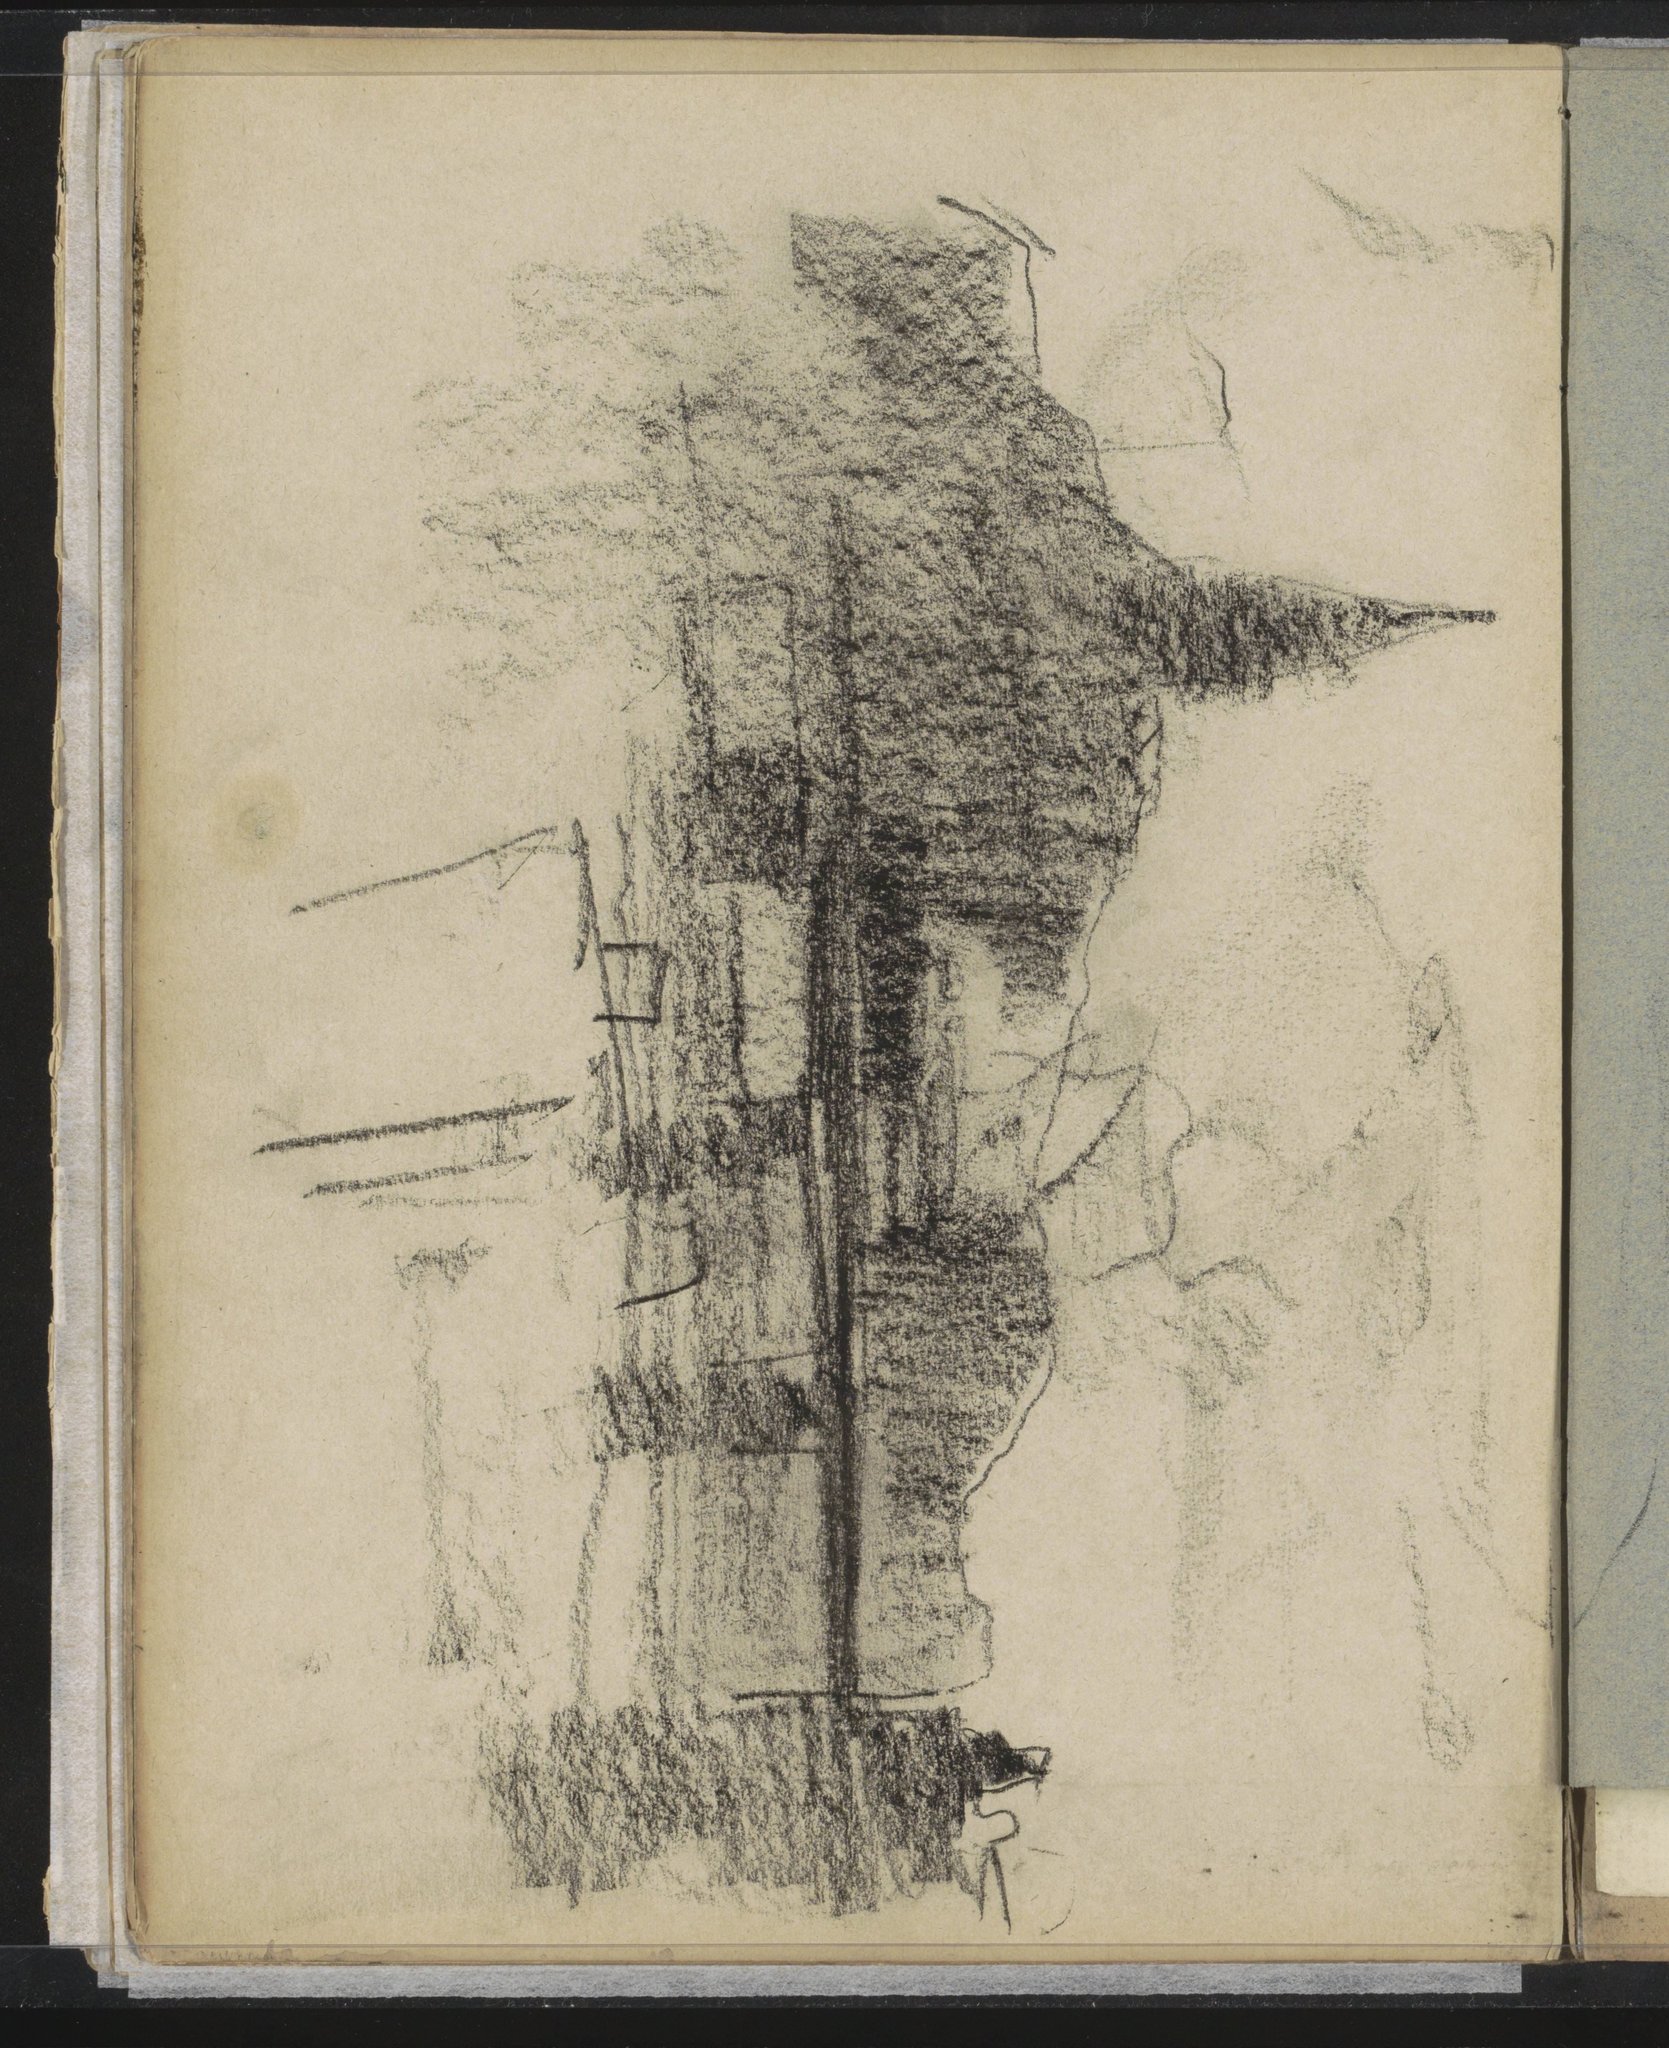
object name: sketchbook leaf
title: Stadsgezicht met een brug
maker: willem witsen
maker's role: draughtsman, painter, print maker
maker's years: 1860-1923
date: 1887-1891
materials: chalk, paper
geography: amsterdam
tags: bridge in city across river, canal, etc., tower, clock tower ~ monumental adornment (+ city(-scape) with figures, staffage), amsterdam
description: Pagina 70 uit een schetsboek met 29 bladen.